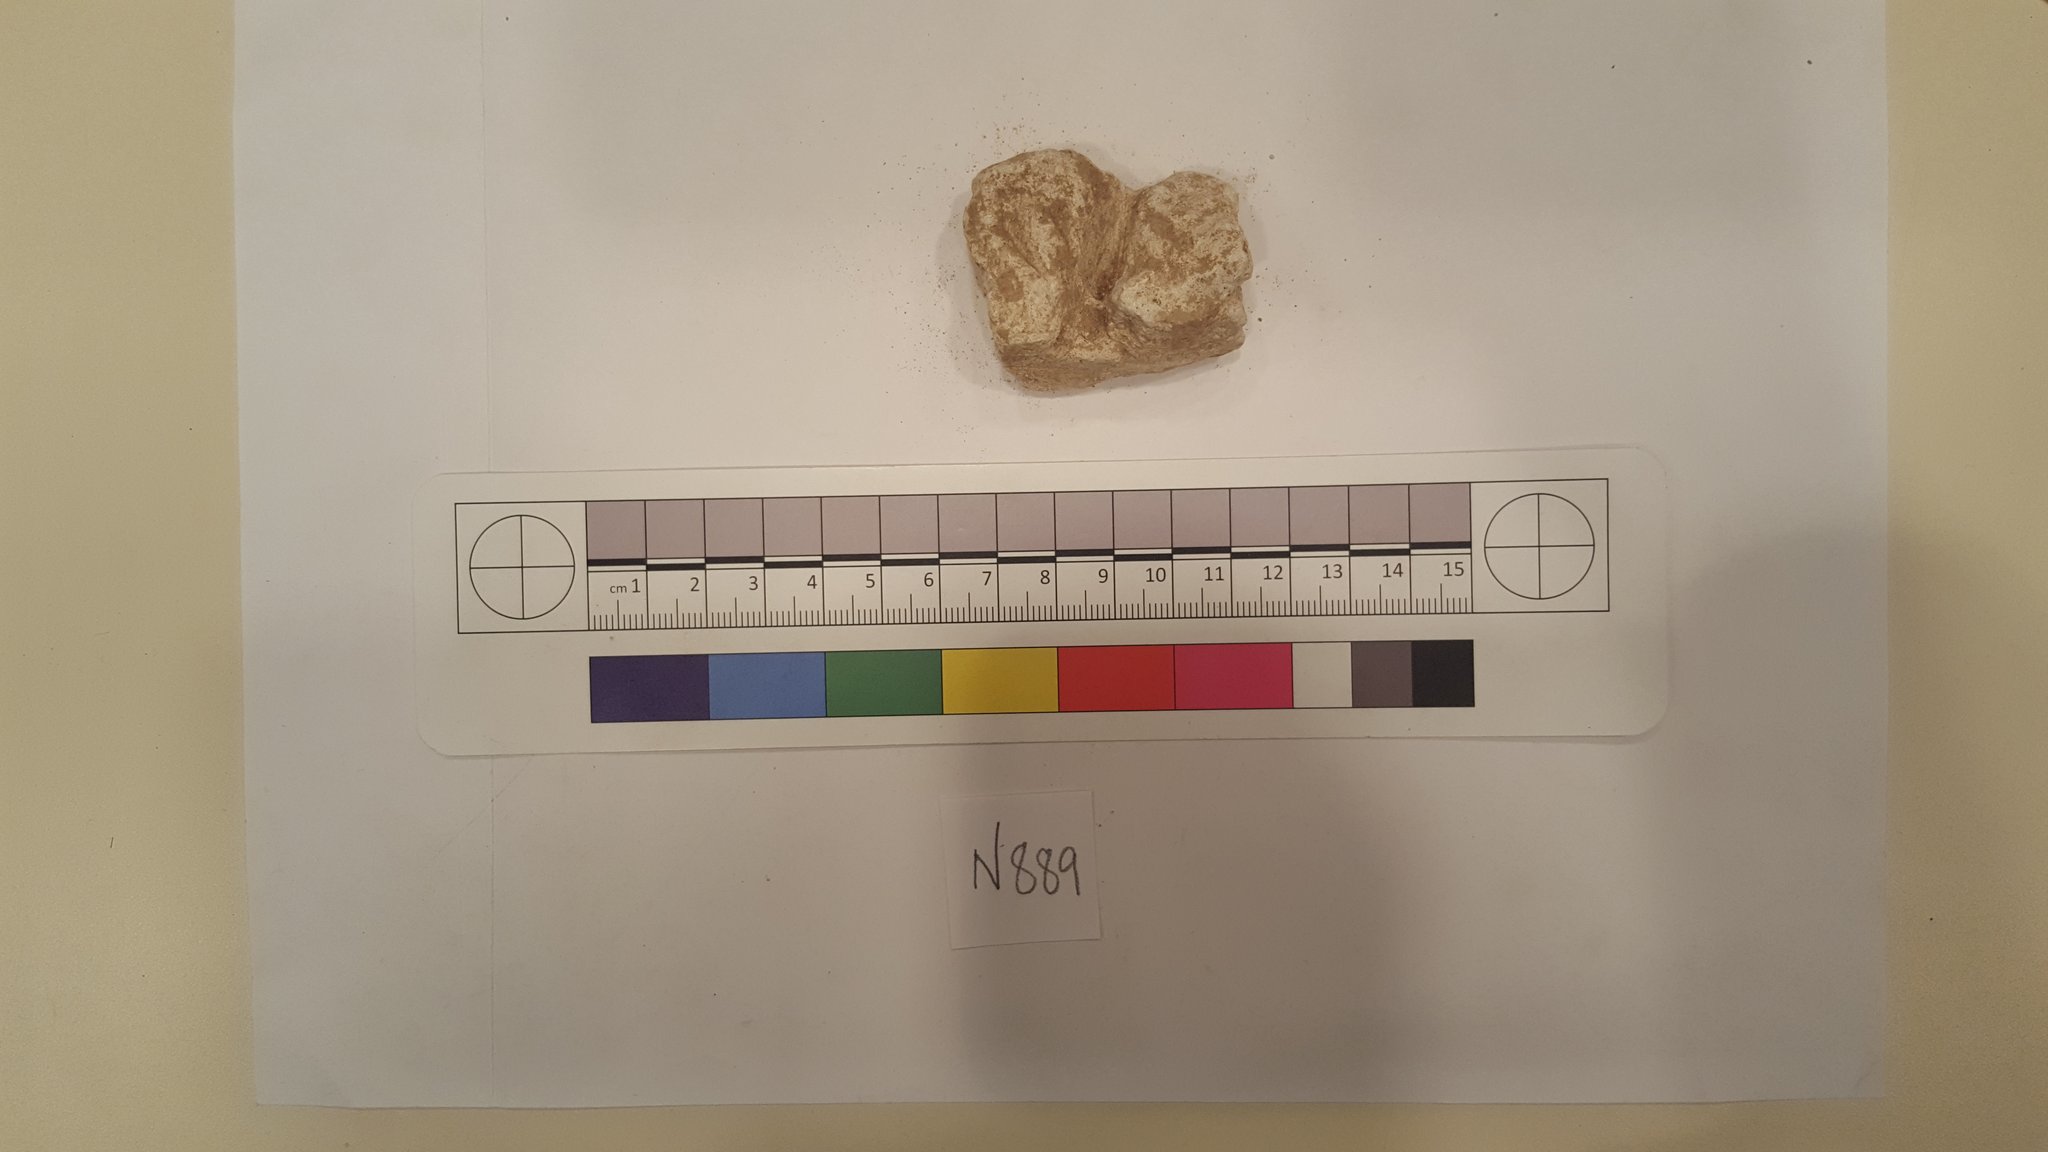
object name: fragment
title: Stucco Fragment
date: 701-1200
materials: plaster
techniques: carving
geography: iran